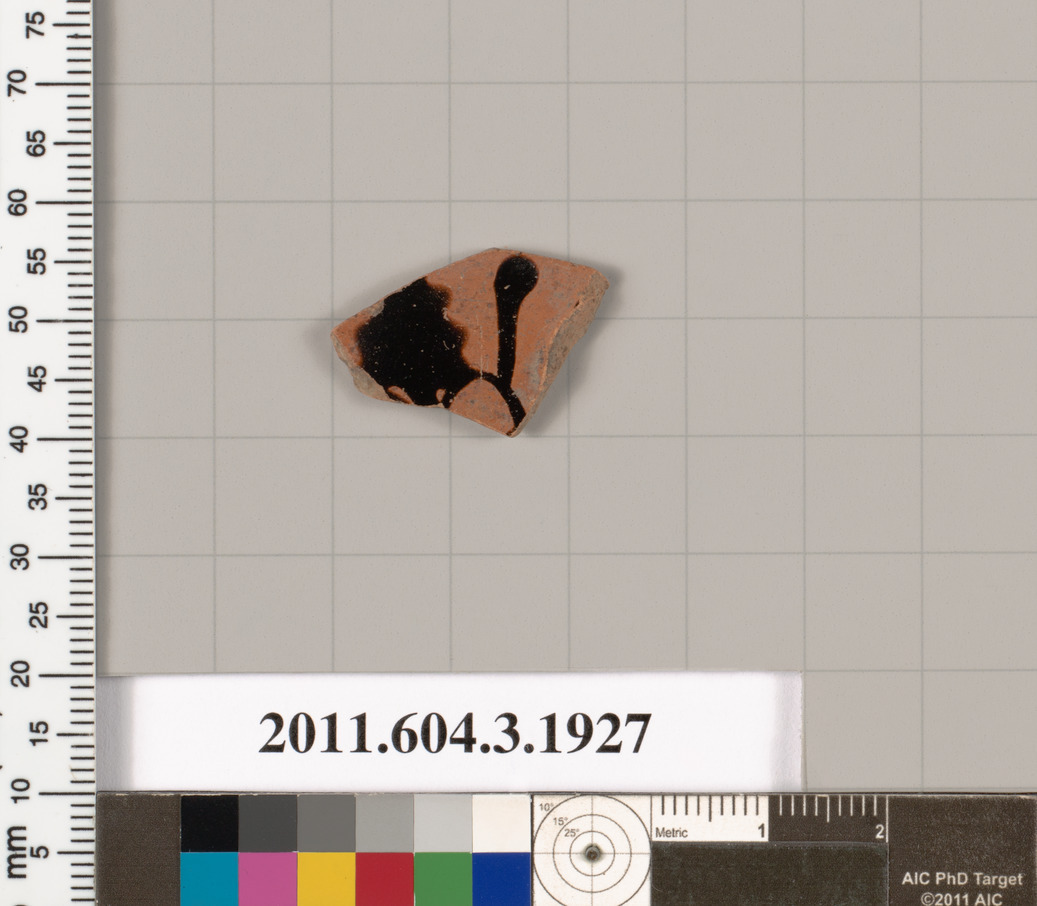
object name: kylix or skyphos fragment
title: Terracotta fragment of a kylix (drinking cup) or a skyphos (deep drinking cup)?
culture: greek, attic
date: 534-468 BCE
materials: terracotta